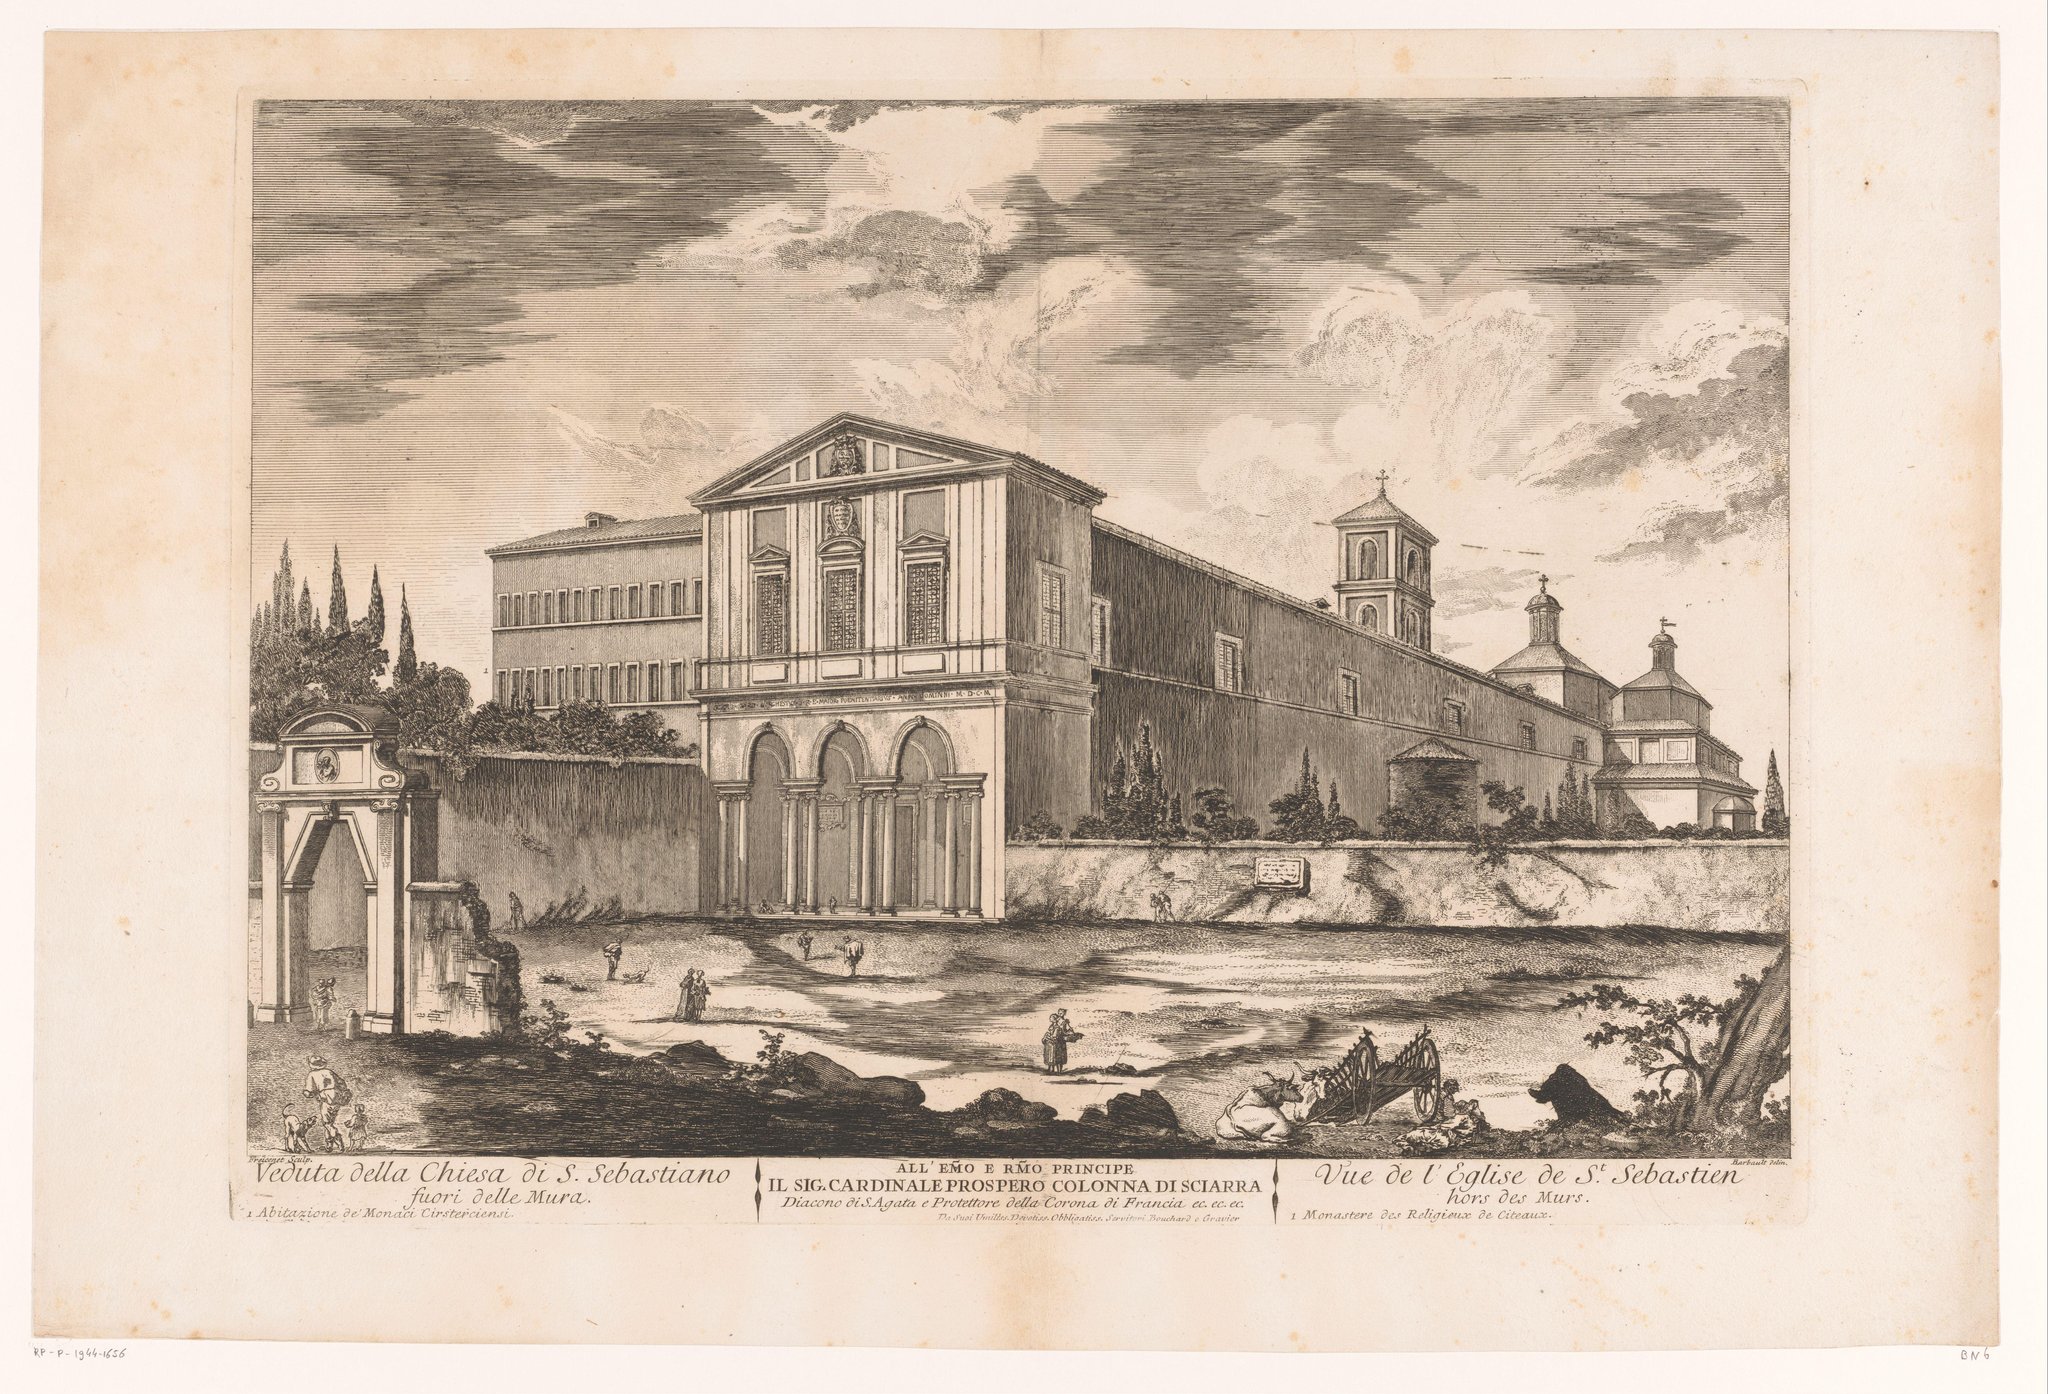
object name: print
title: Gezicht op de Sint-Sebastiaan buiten de Muren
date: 1763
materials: paper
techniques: etching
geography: rome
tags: city-view in general; 'veduta', church (exterior)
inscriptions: collector's mark: Lugt 2228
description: Prent gebruikt voor: Barbault, Jean. Les plus beaux édifices de Rome moderne publiés par Jean Barbault peintre (...). Rome: Bouchard et Gravier, 1763.